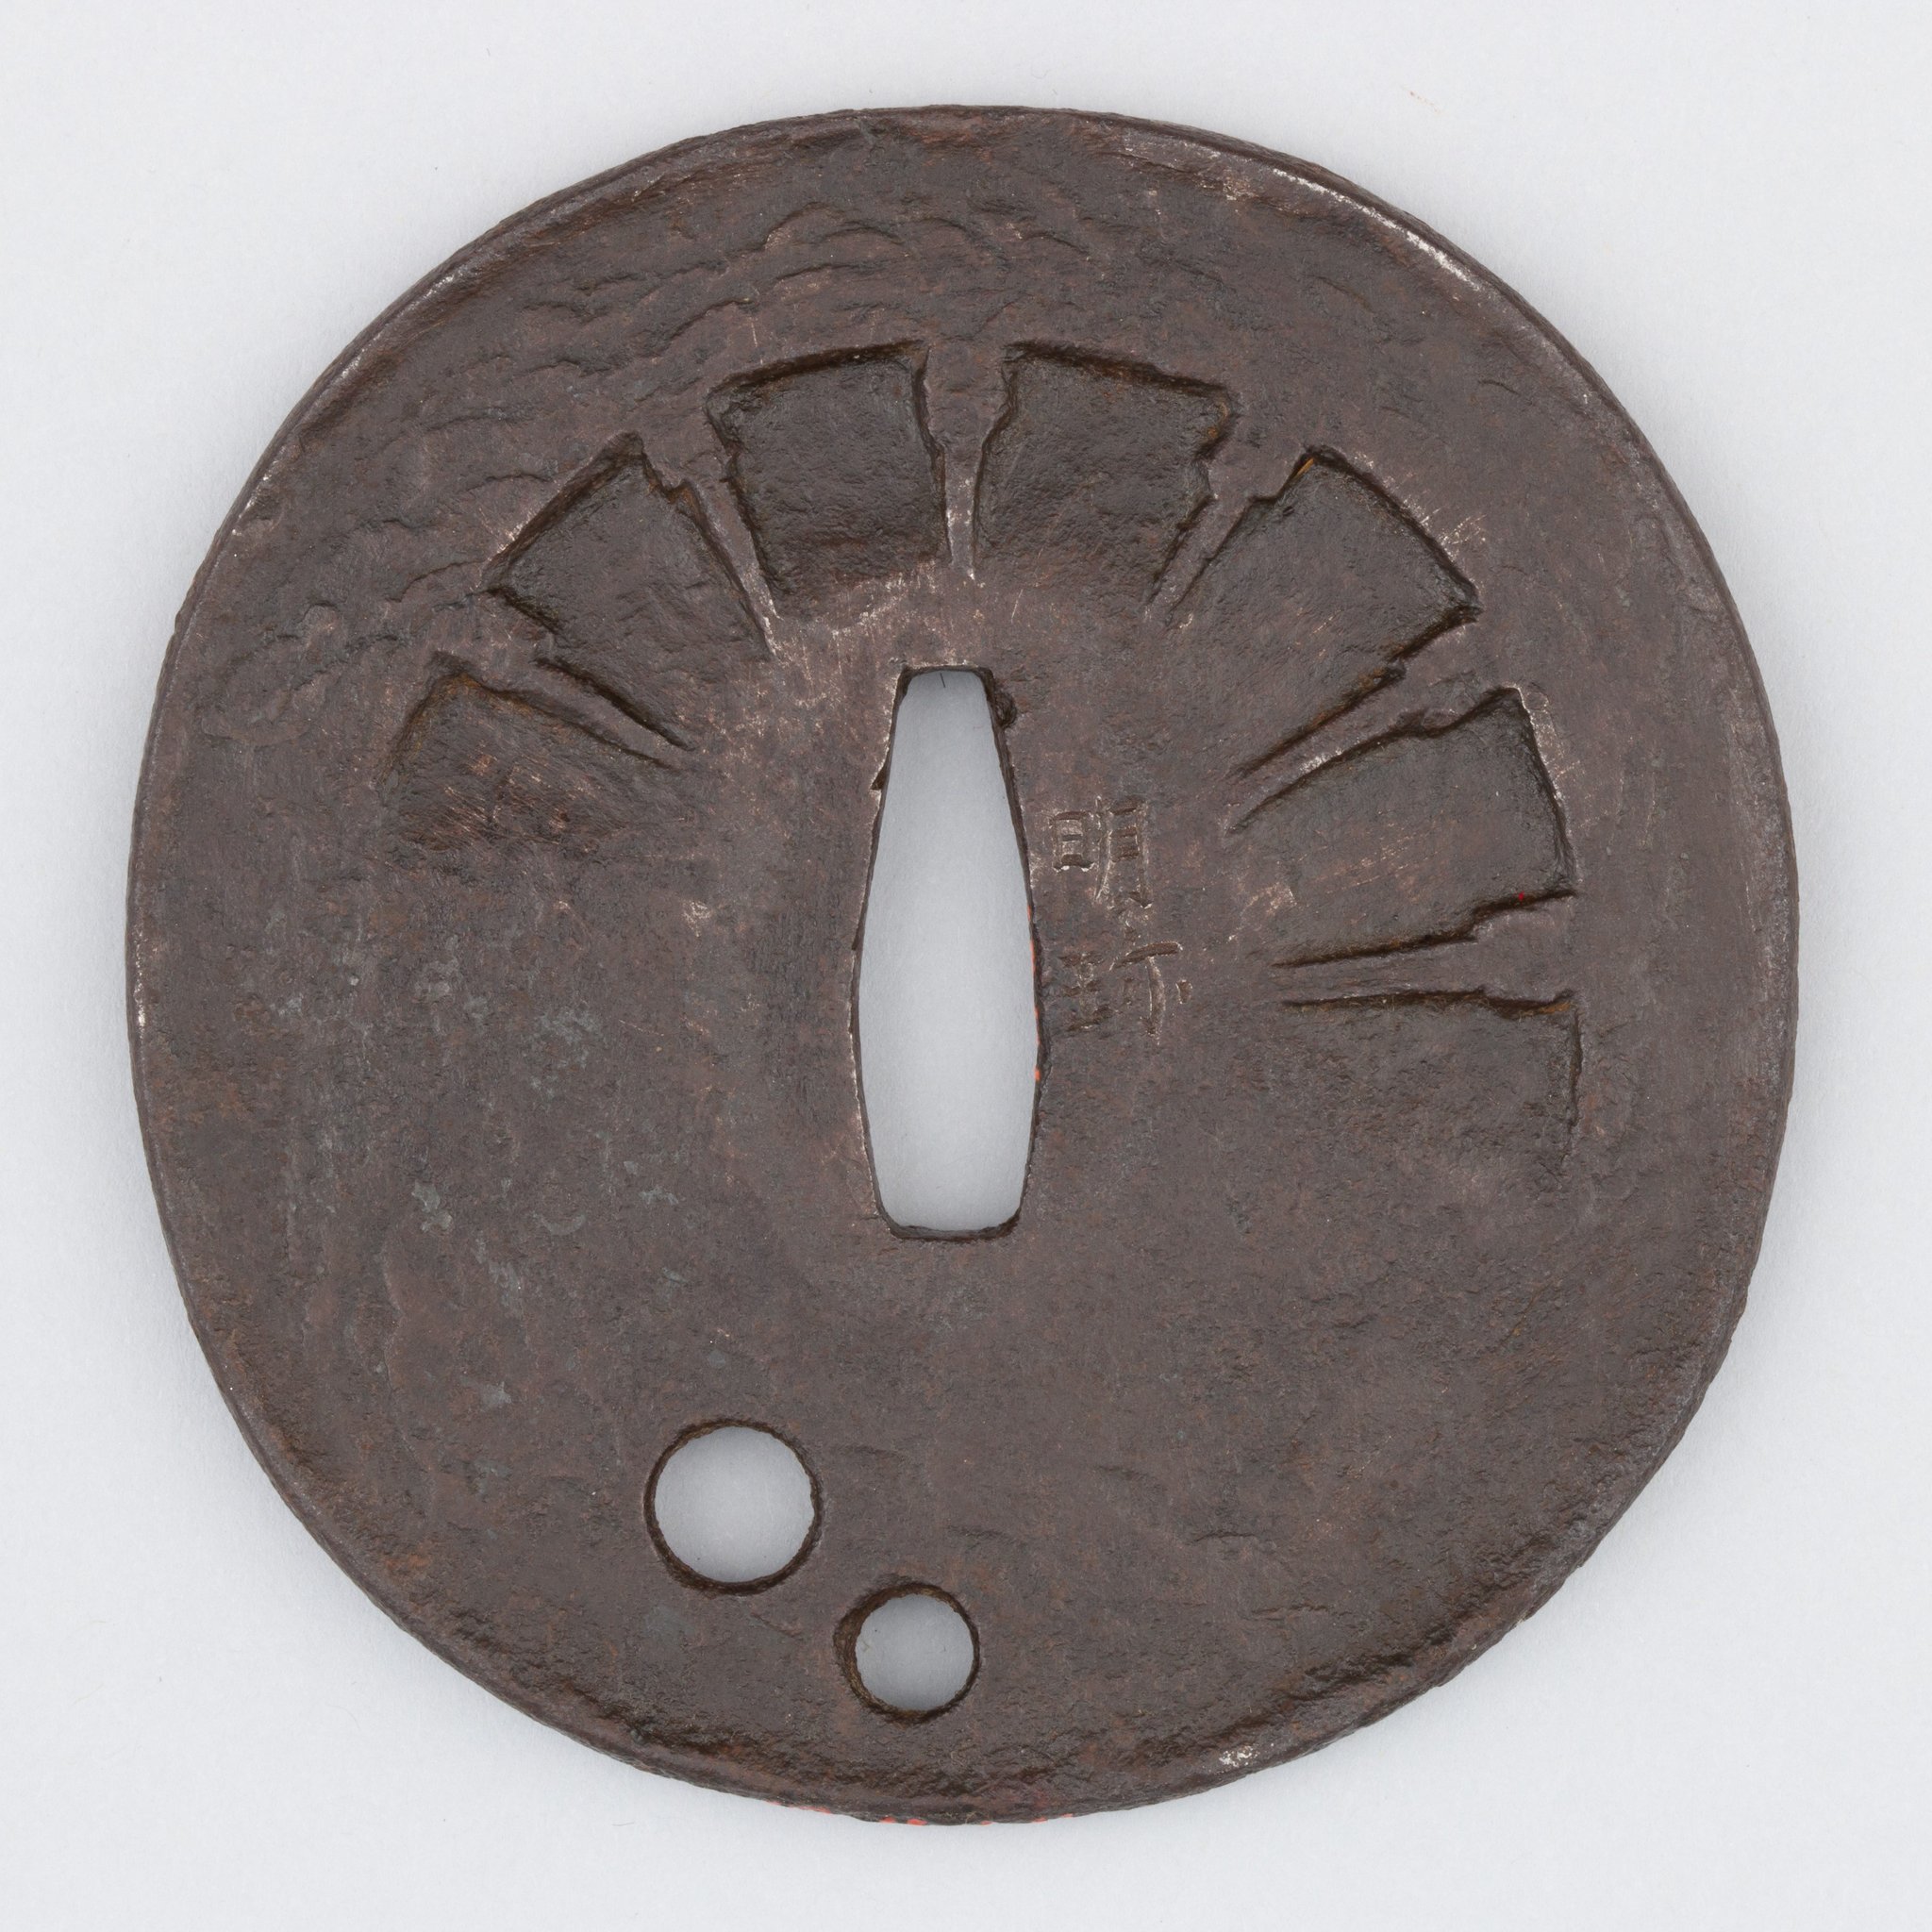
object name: sword guard tsuba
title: Sword Guard (Tsuba)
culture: japanese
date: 1501-1600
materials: copper, iron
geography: japan